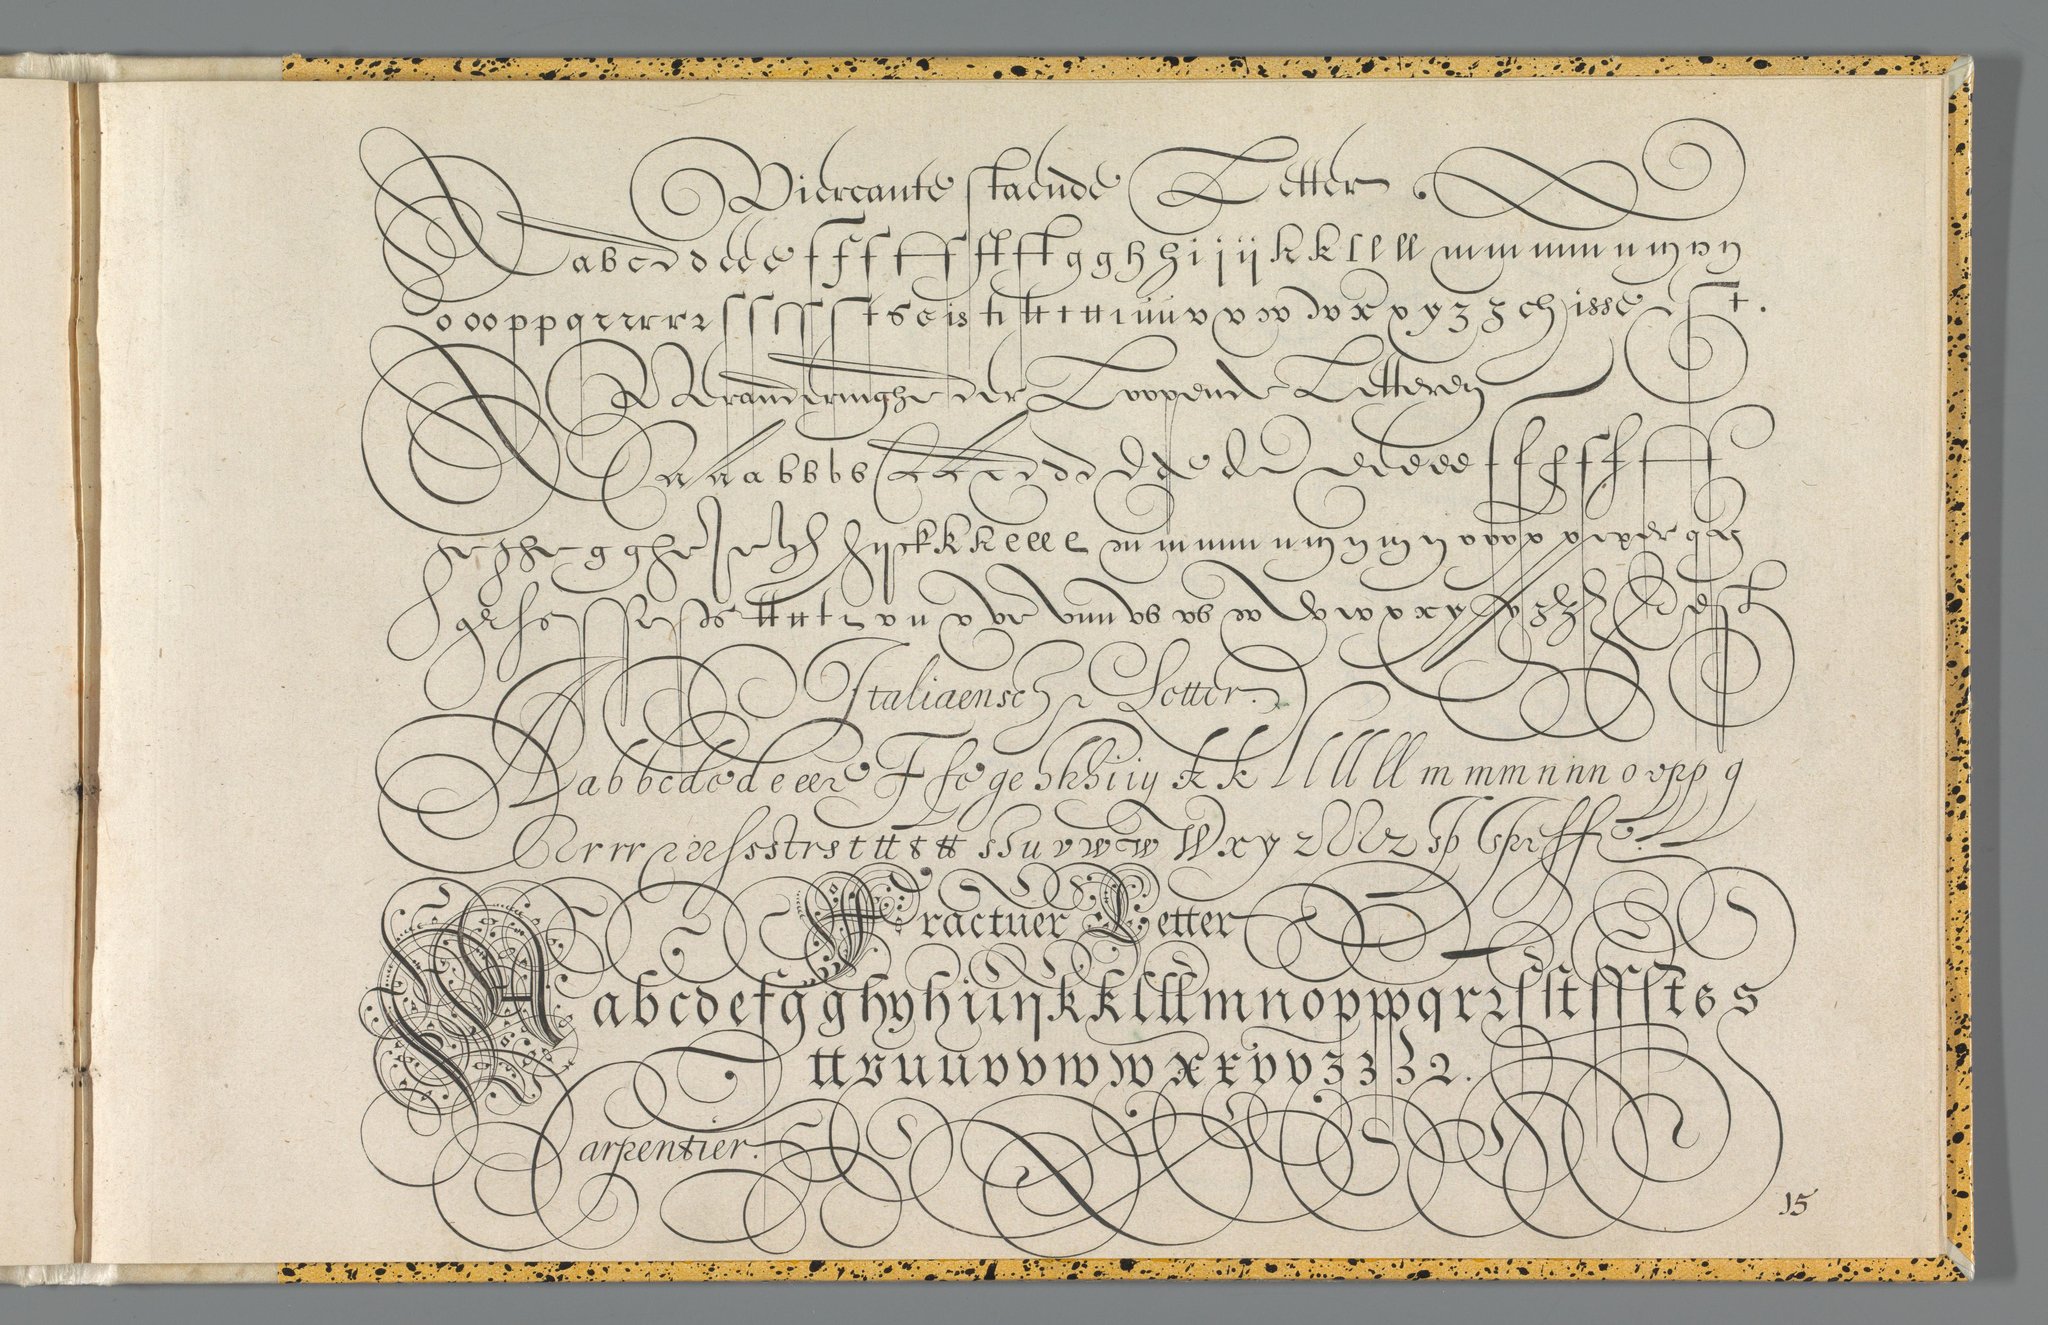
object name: album leaf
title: Exemplaer-Boeck. Inhoudende d'alder-gebruyckelyckste Geschriften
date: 1618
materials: paper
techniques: engraving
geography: amsterdam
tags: letters, alphabet, script, calligraphy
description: Schrijfvoorbeeld met het alfabet in vier verschillende lettertypes. Deze prent maakt deel uit van een album.